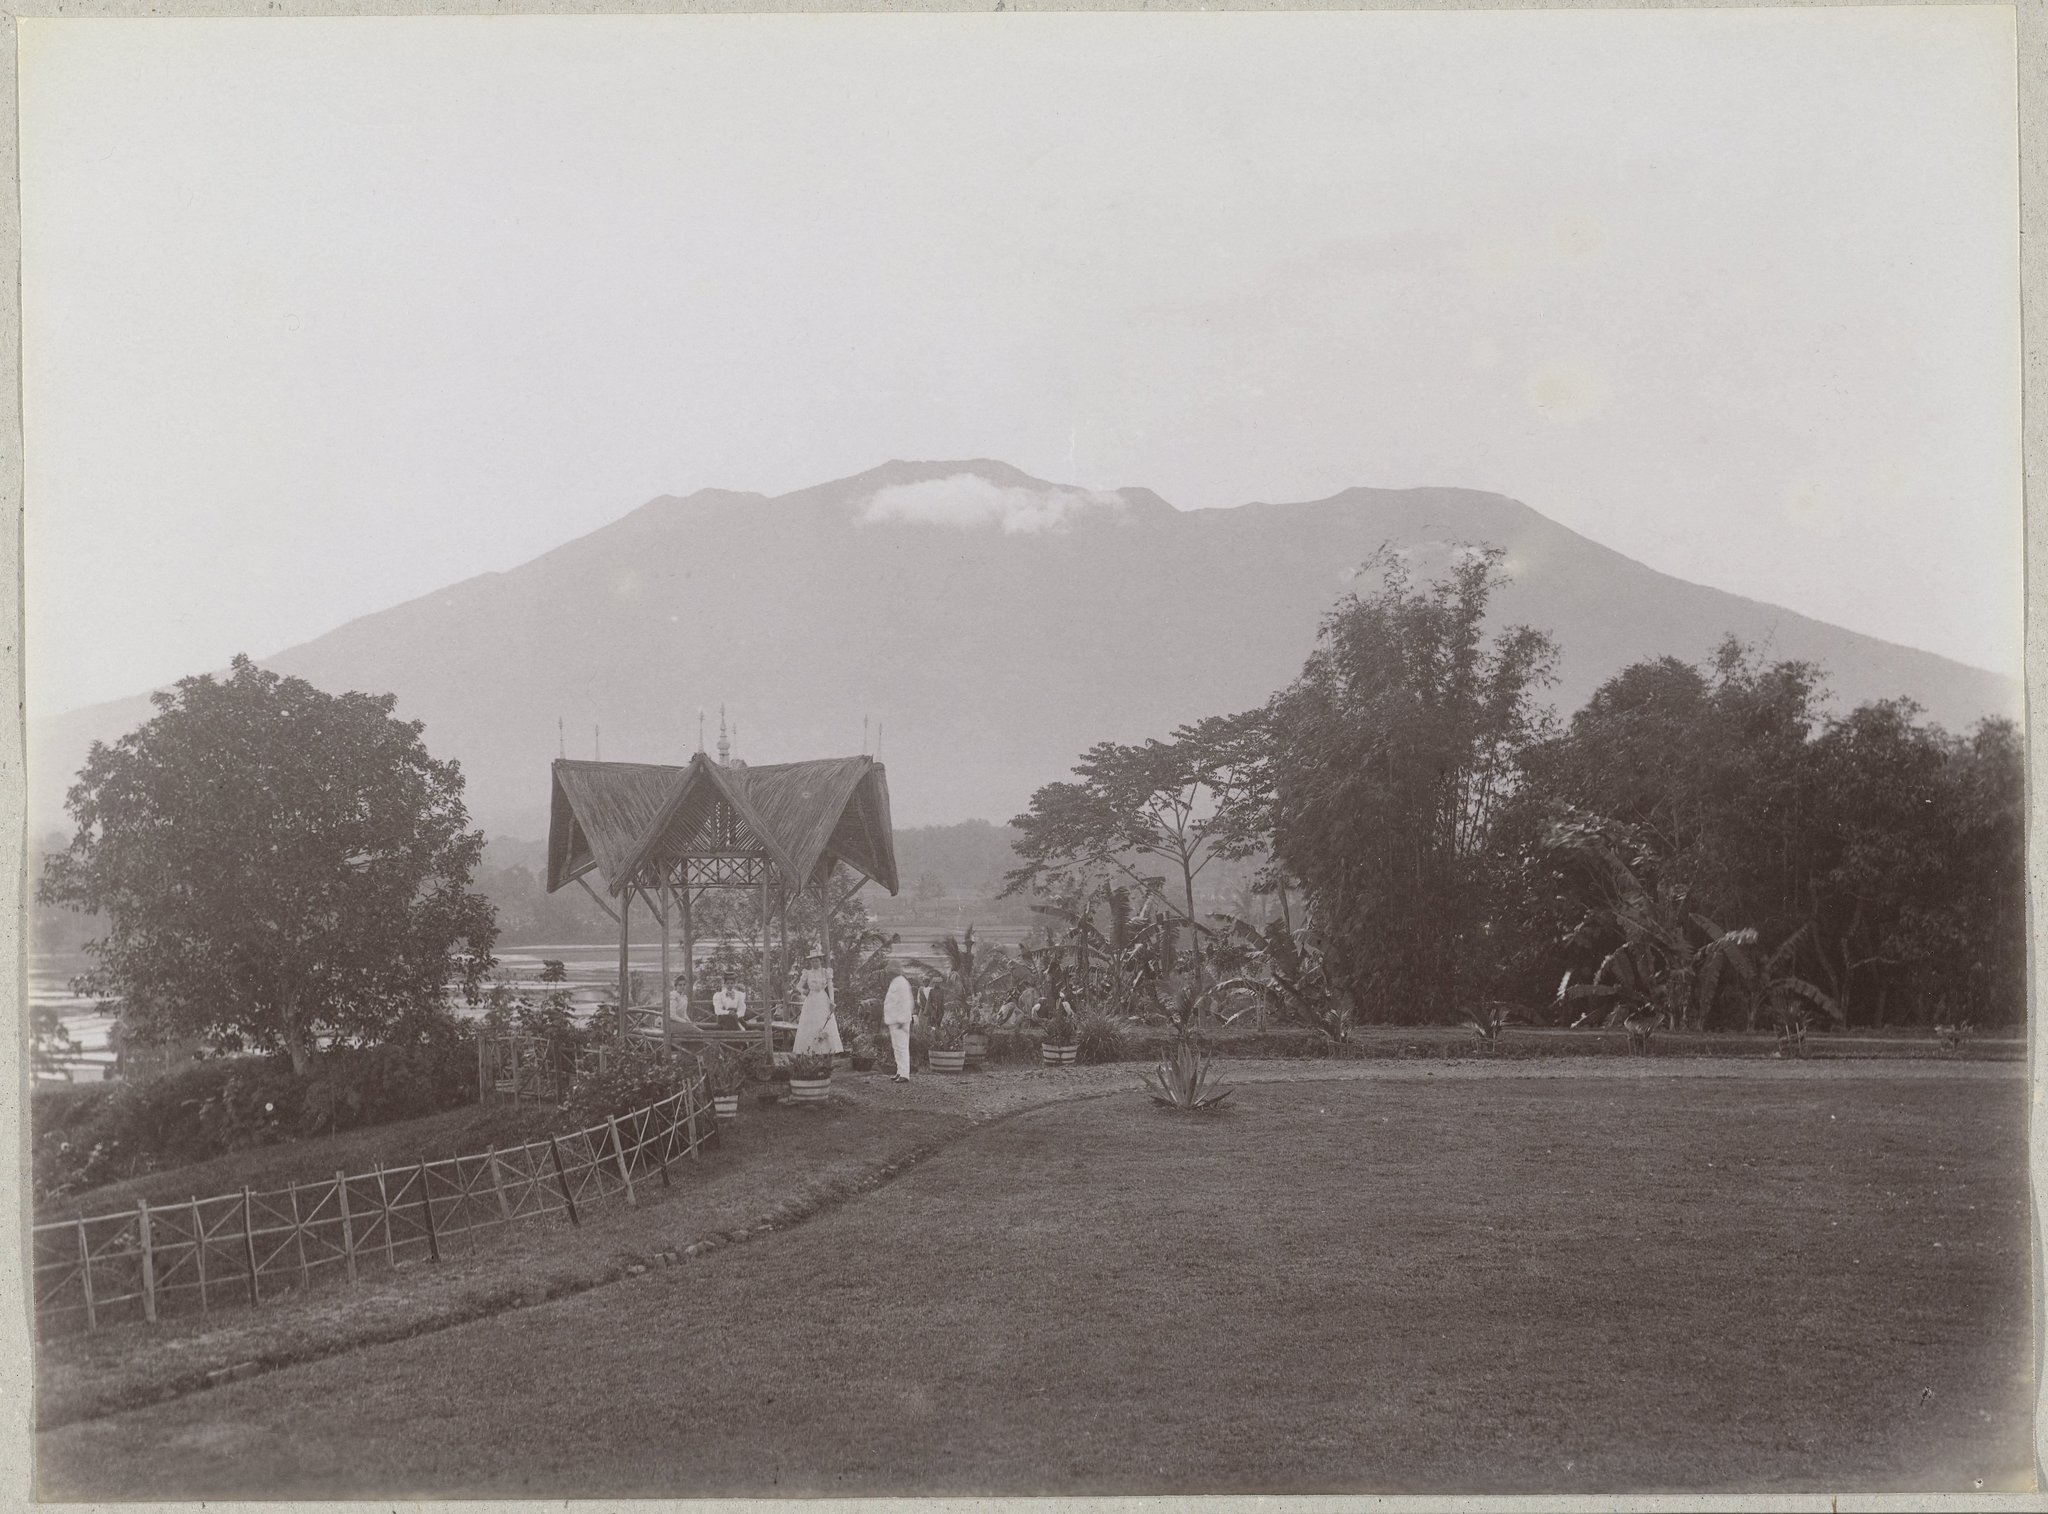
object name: photograph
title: Stormpark Fort de Kock in Bukittinggi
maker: christiaan benjamin nieuwenhuis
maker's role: publisher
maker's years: 1863-1922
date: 1891-1912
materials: paper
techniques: albumen print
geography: bukittinggi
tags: public gardens, park (+ city(-scape) with figures, staffage), summer-house, arbour, garden-house (dutch: 'theekoepel'), mountains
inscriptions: inscription: ‘Stormpark Fort de Kock’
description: Een aantal vrouwen in een overdekte zitplaats aan de rand van een tuin in Fort de Kock op Sumatra. Op de achtergrond is een vulkaan zichtbaar.